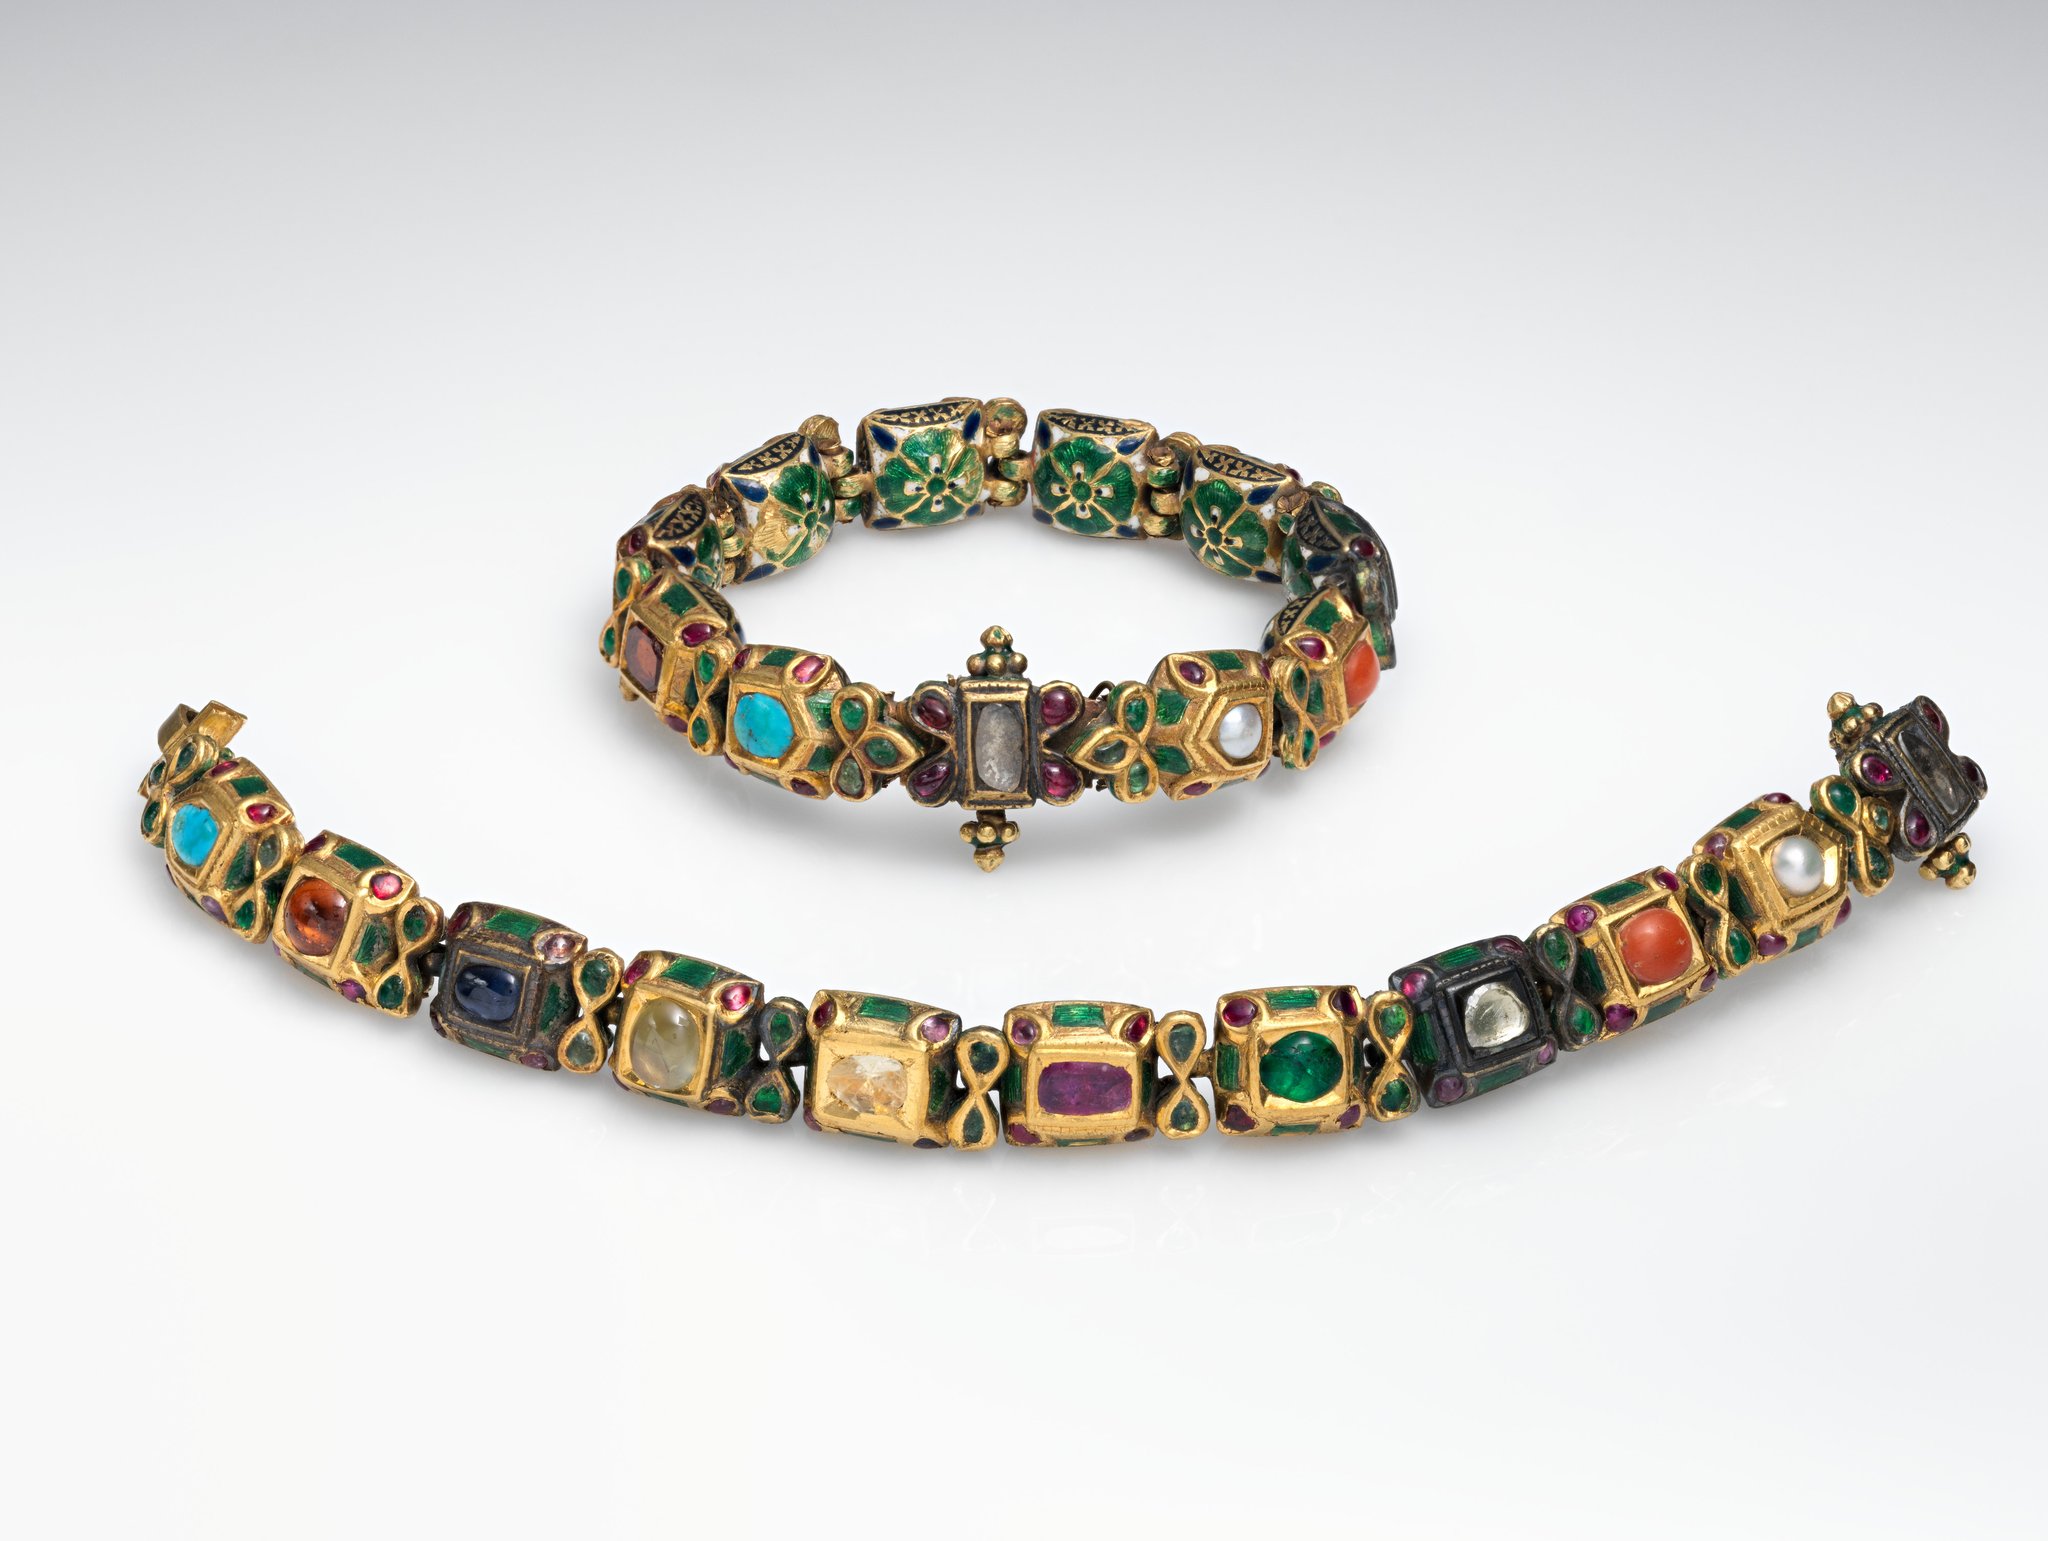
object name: bracelet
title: Nine-Gem (Navaratna) Talismanic Bracelet, One of a Pair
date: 1801-1900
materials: stone, coral, diamond, gemstone, enamel, garnet, gold, pearl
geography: northern india